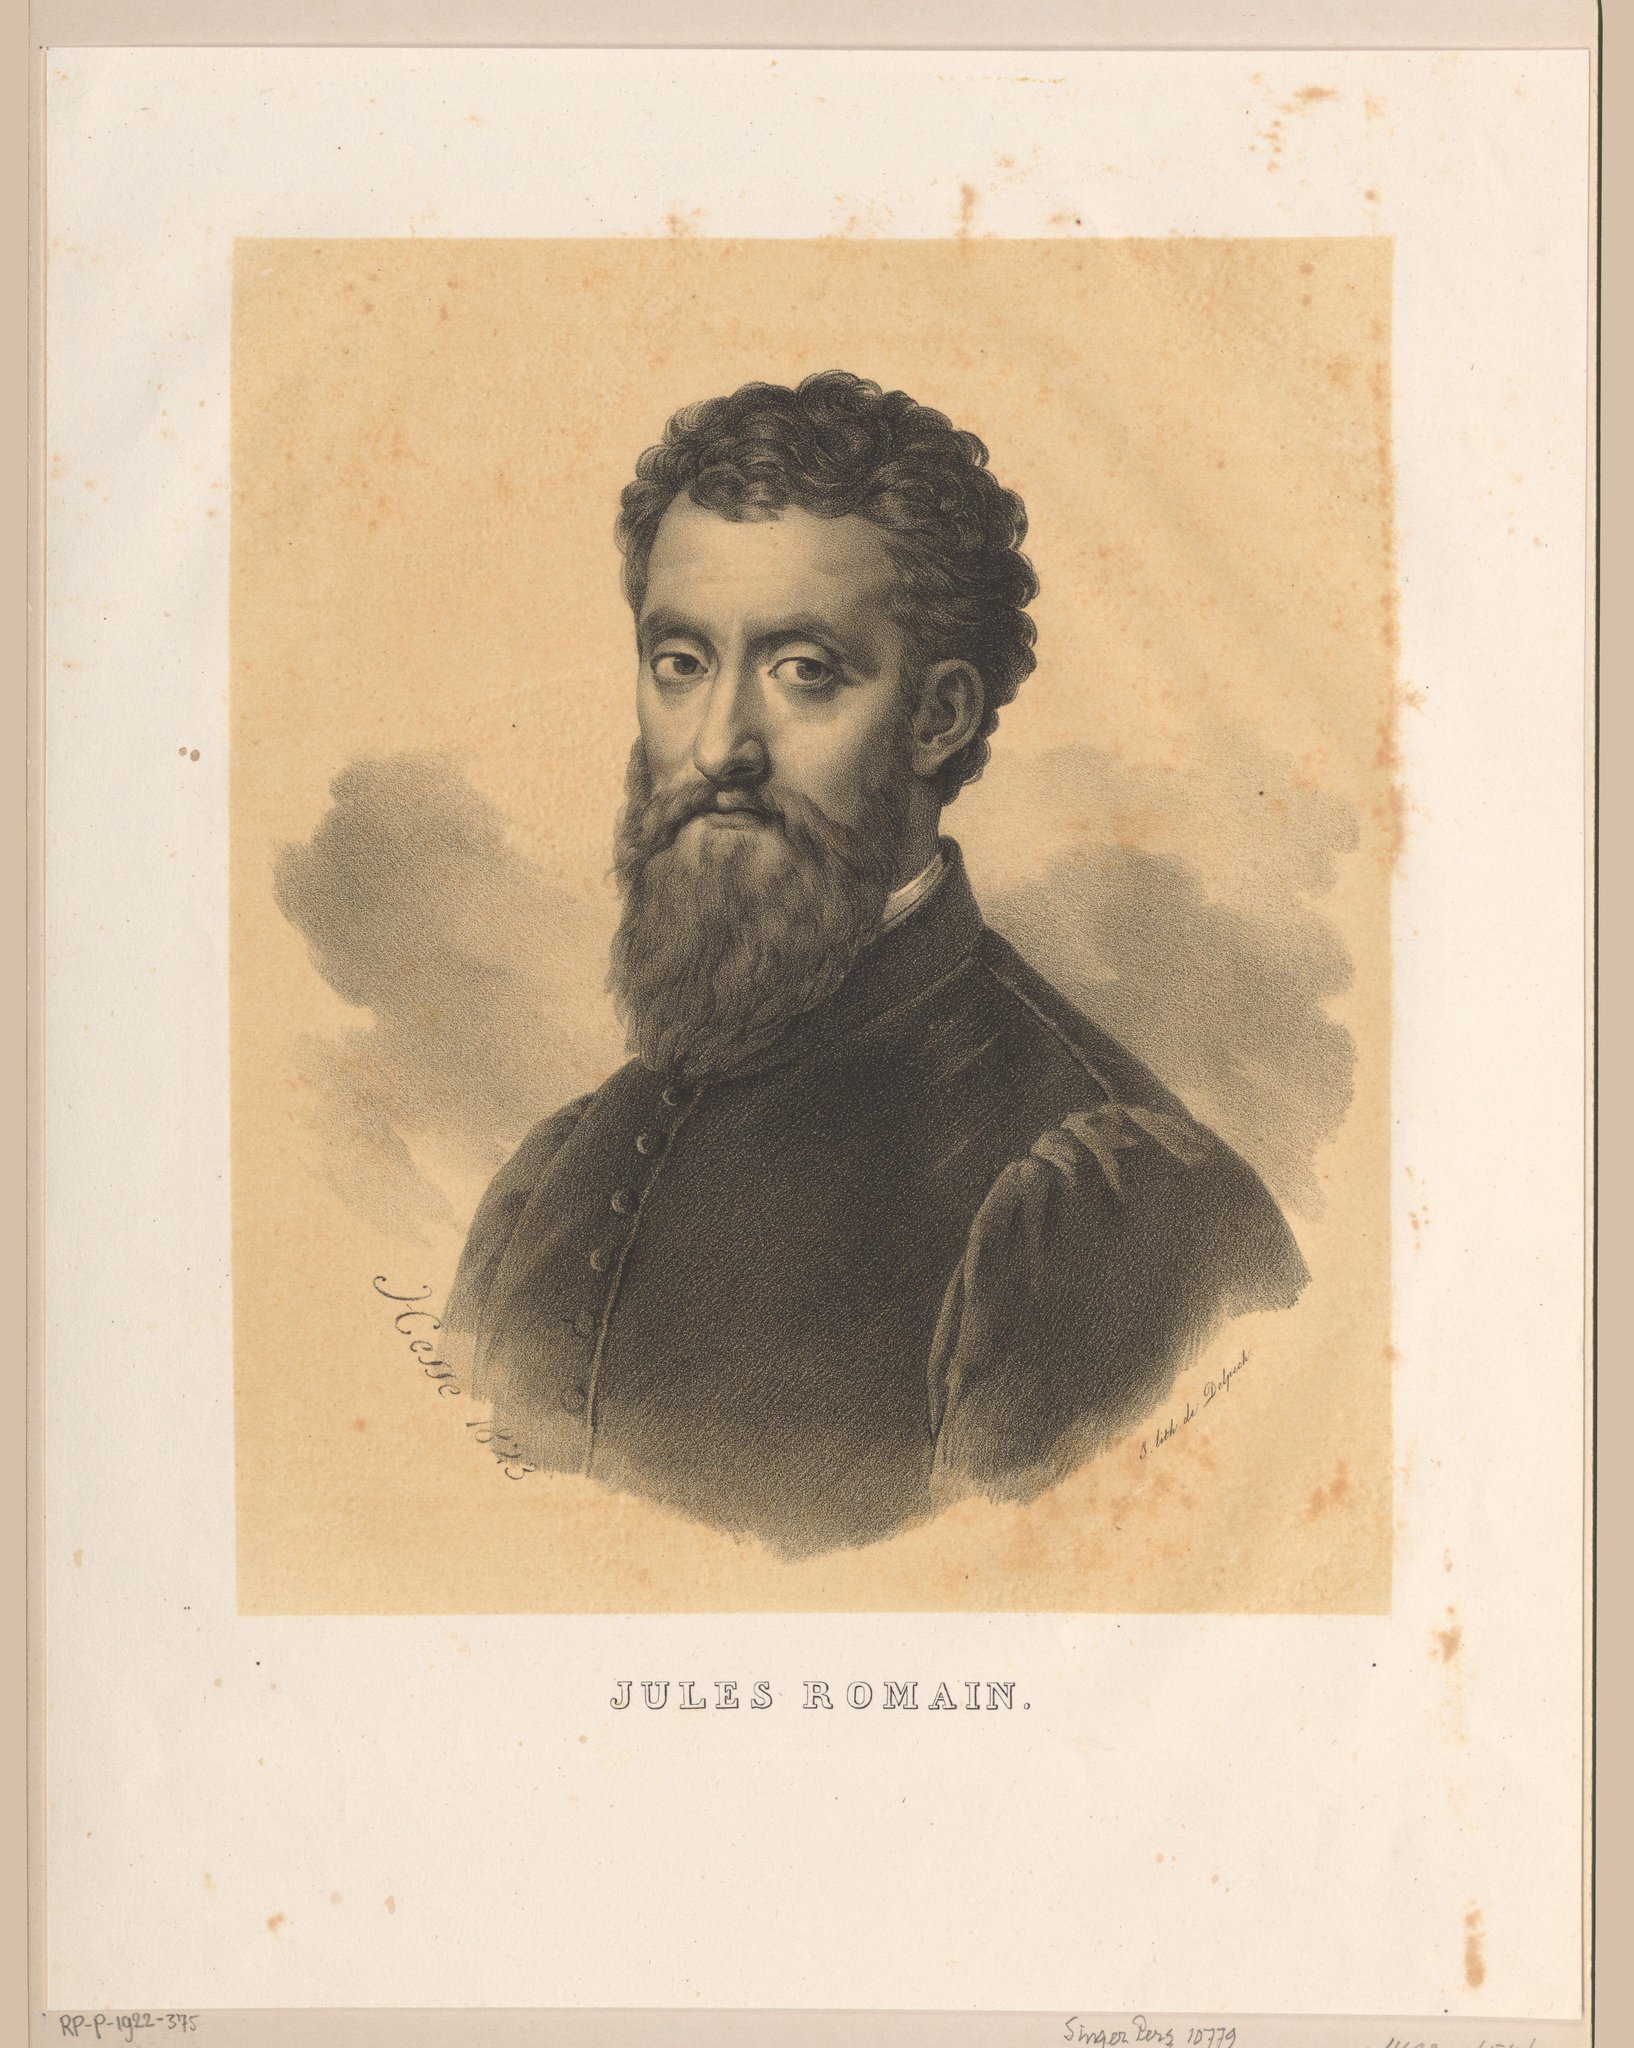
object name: print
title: Portret van Giulio Romano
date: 1823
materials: paper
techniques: tone lithography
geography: paris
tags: rome, painter, print maker, draughtsman, giulio romano, historical persons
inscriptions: collector's mark: Lugt 2228